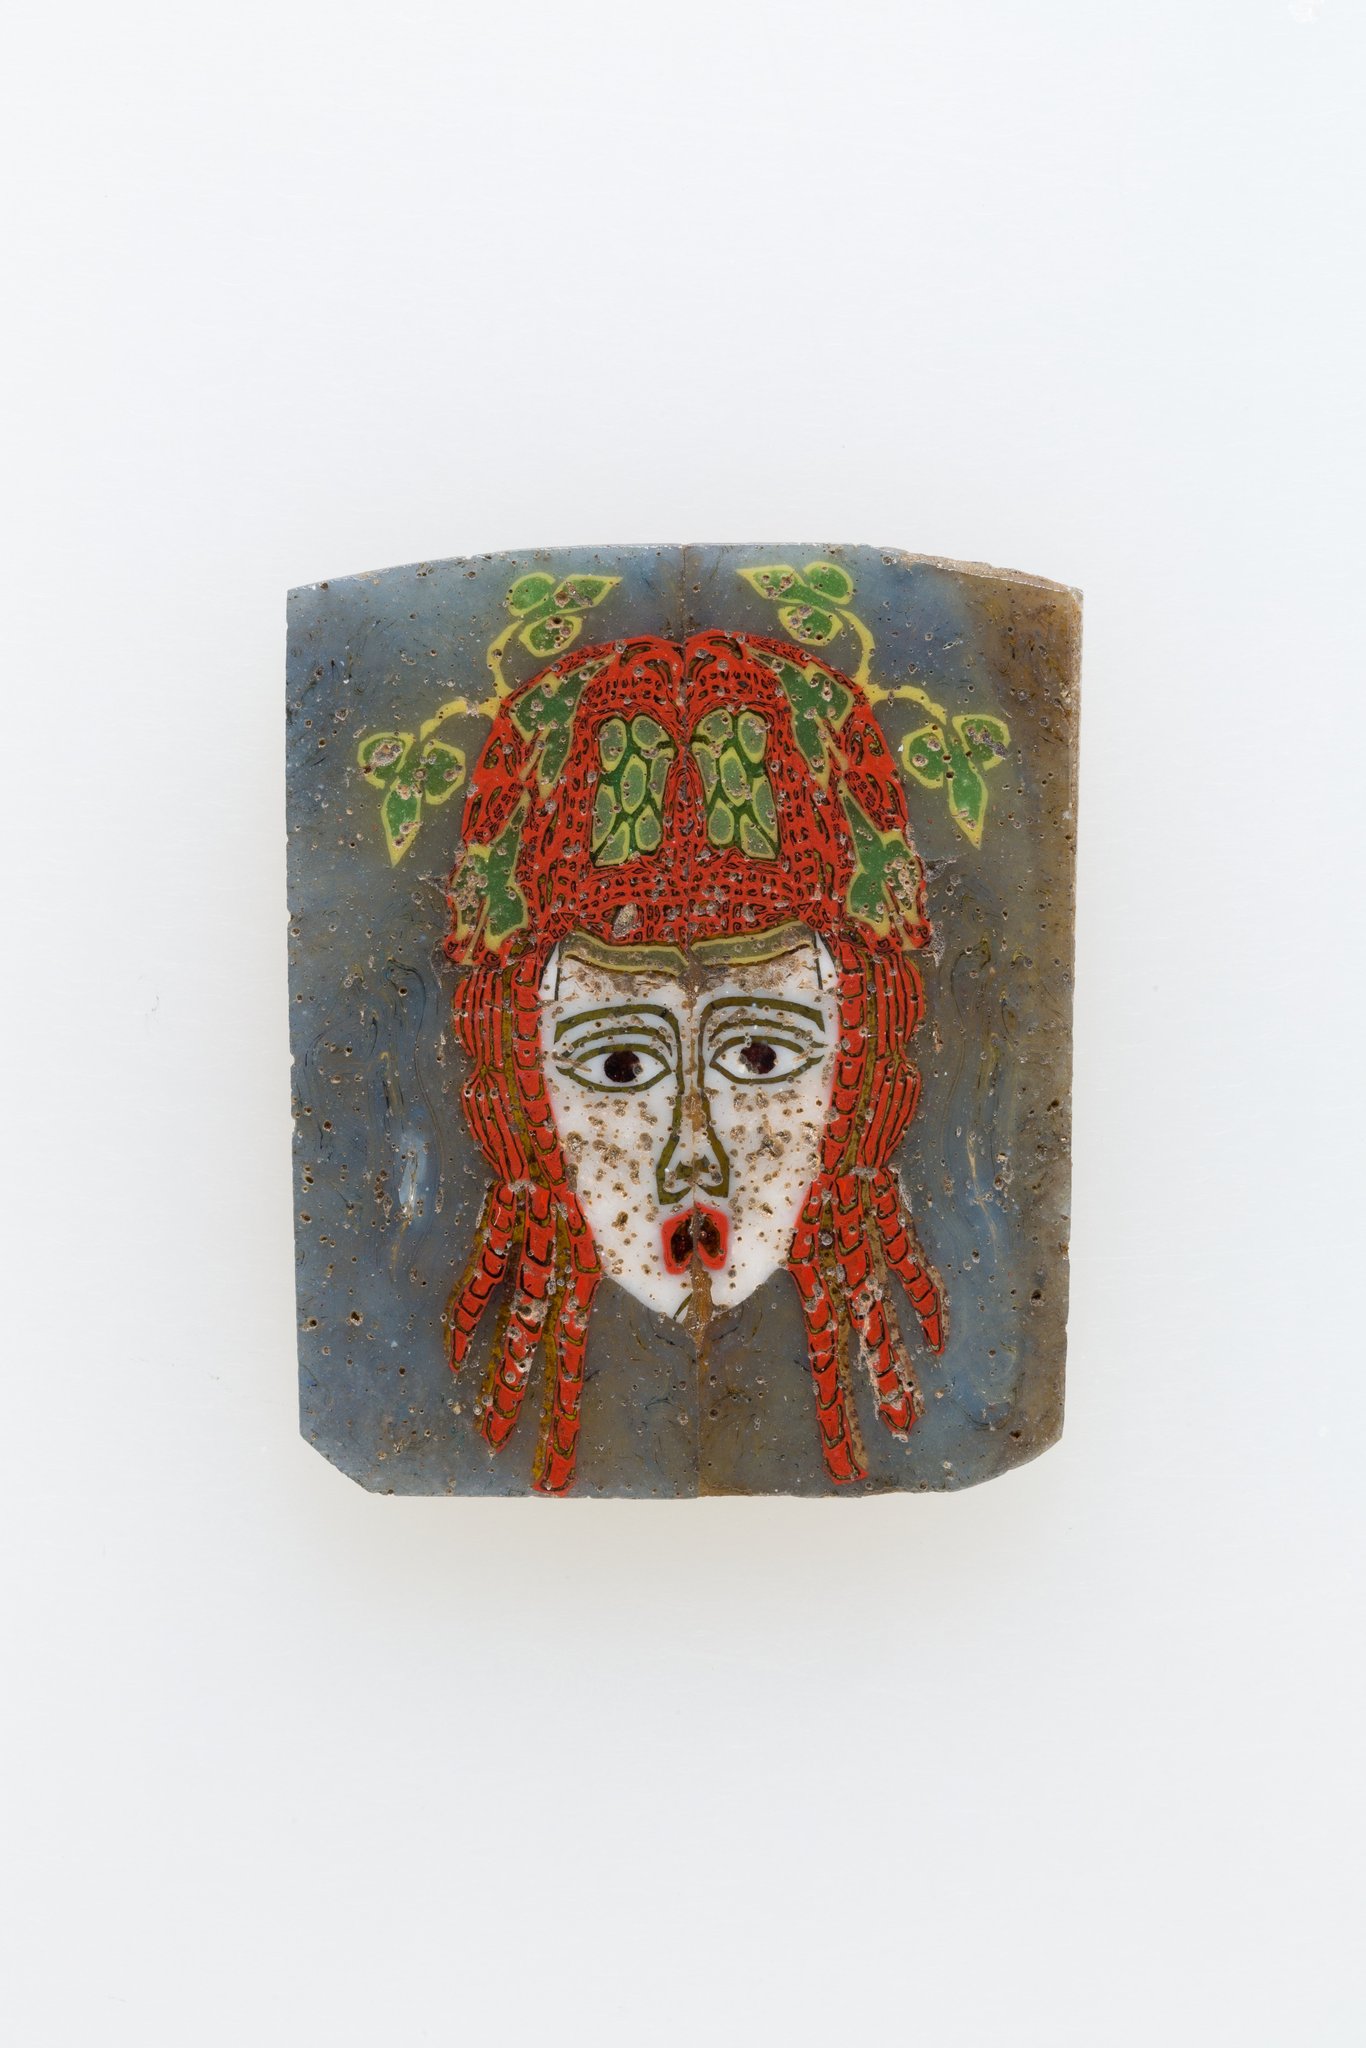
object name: plaque, female face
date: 100 BCE-100 CE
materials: glass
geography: egypt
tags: faces,women